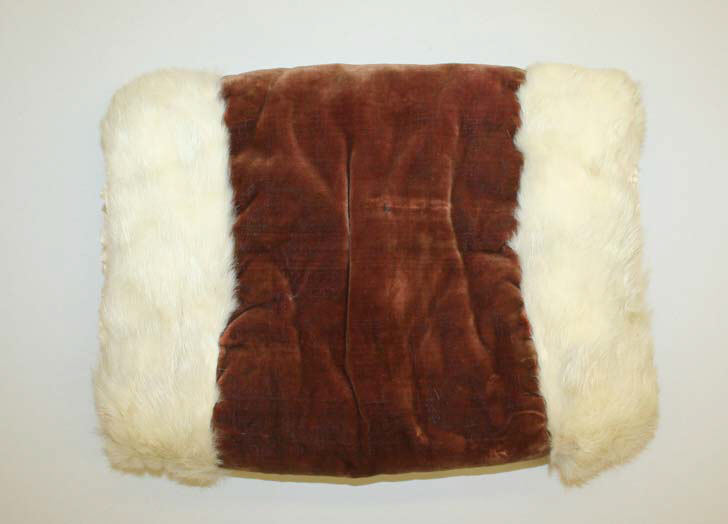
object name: muff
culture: european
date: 1850-1859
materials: fur, silk